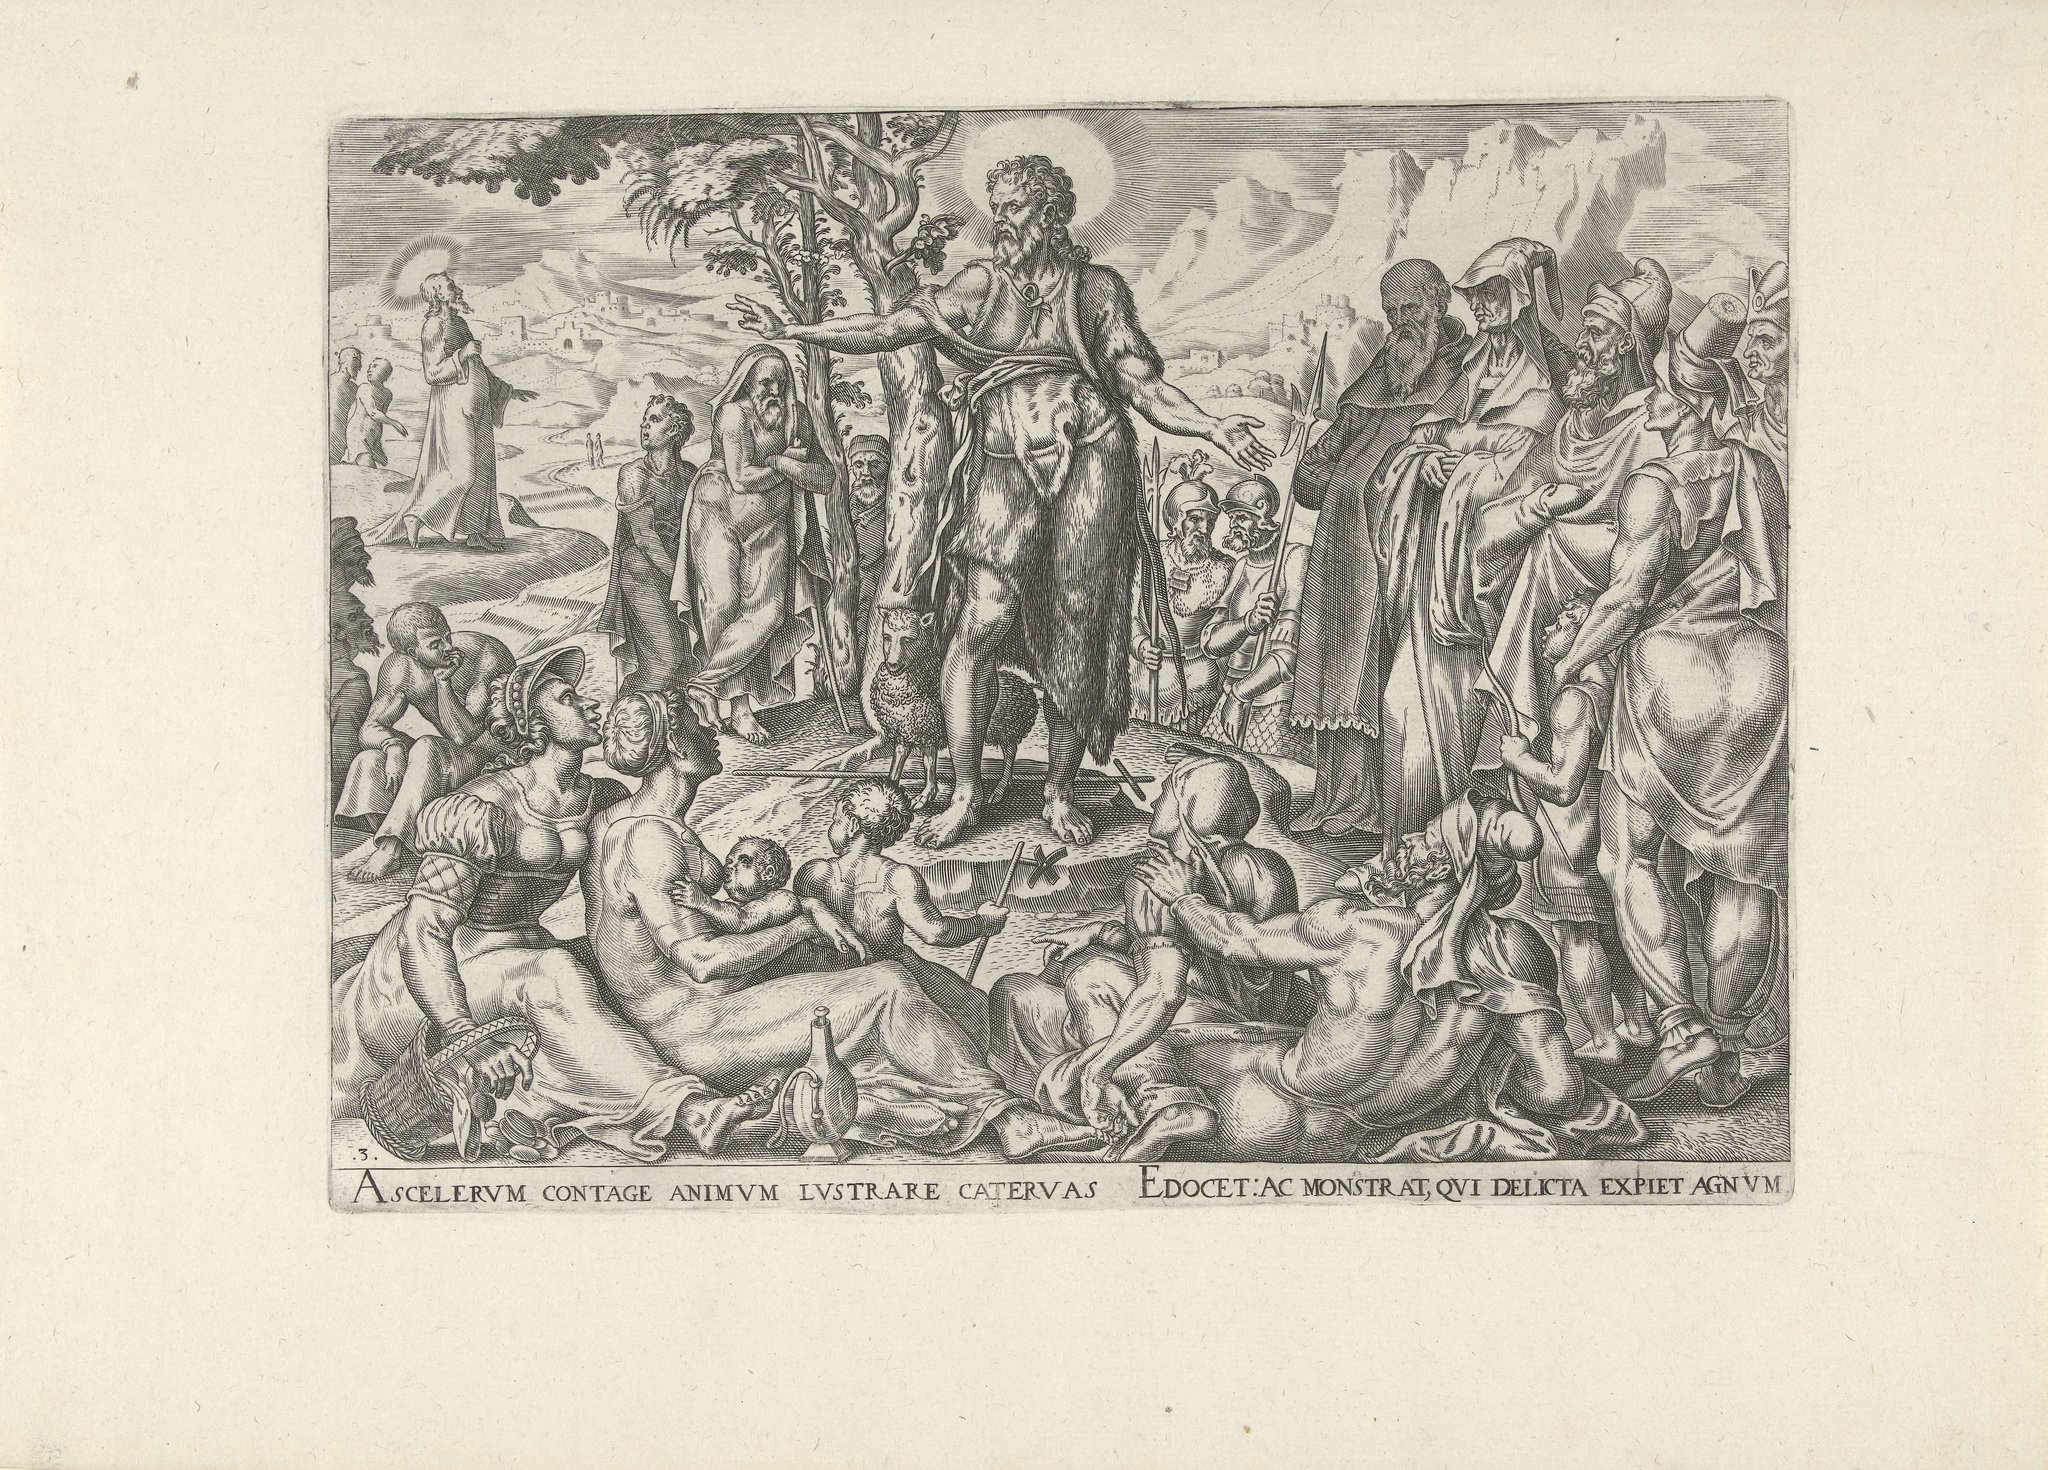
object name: print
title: Geschiedenis van Johannes de Doper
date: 1564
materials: paper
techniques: engraving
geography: haarlem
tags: series of scenes from the life of john the baptist, john the baptist preaching (perhaps christ among the bystanders)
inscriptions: collector's mark: Lugt 2760, collector's mark: Lugt 2228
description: Johannes de Doper staat met zijn lam op een verhoging en preekt tot een groep mensen. Linksachter staat Christus, apart van de groep.